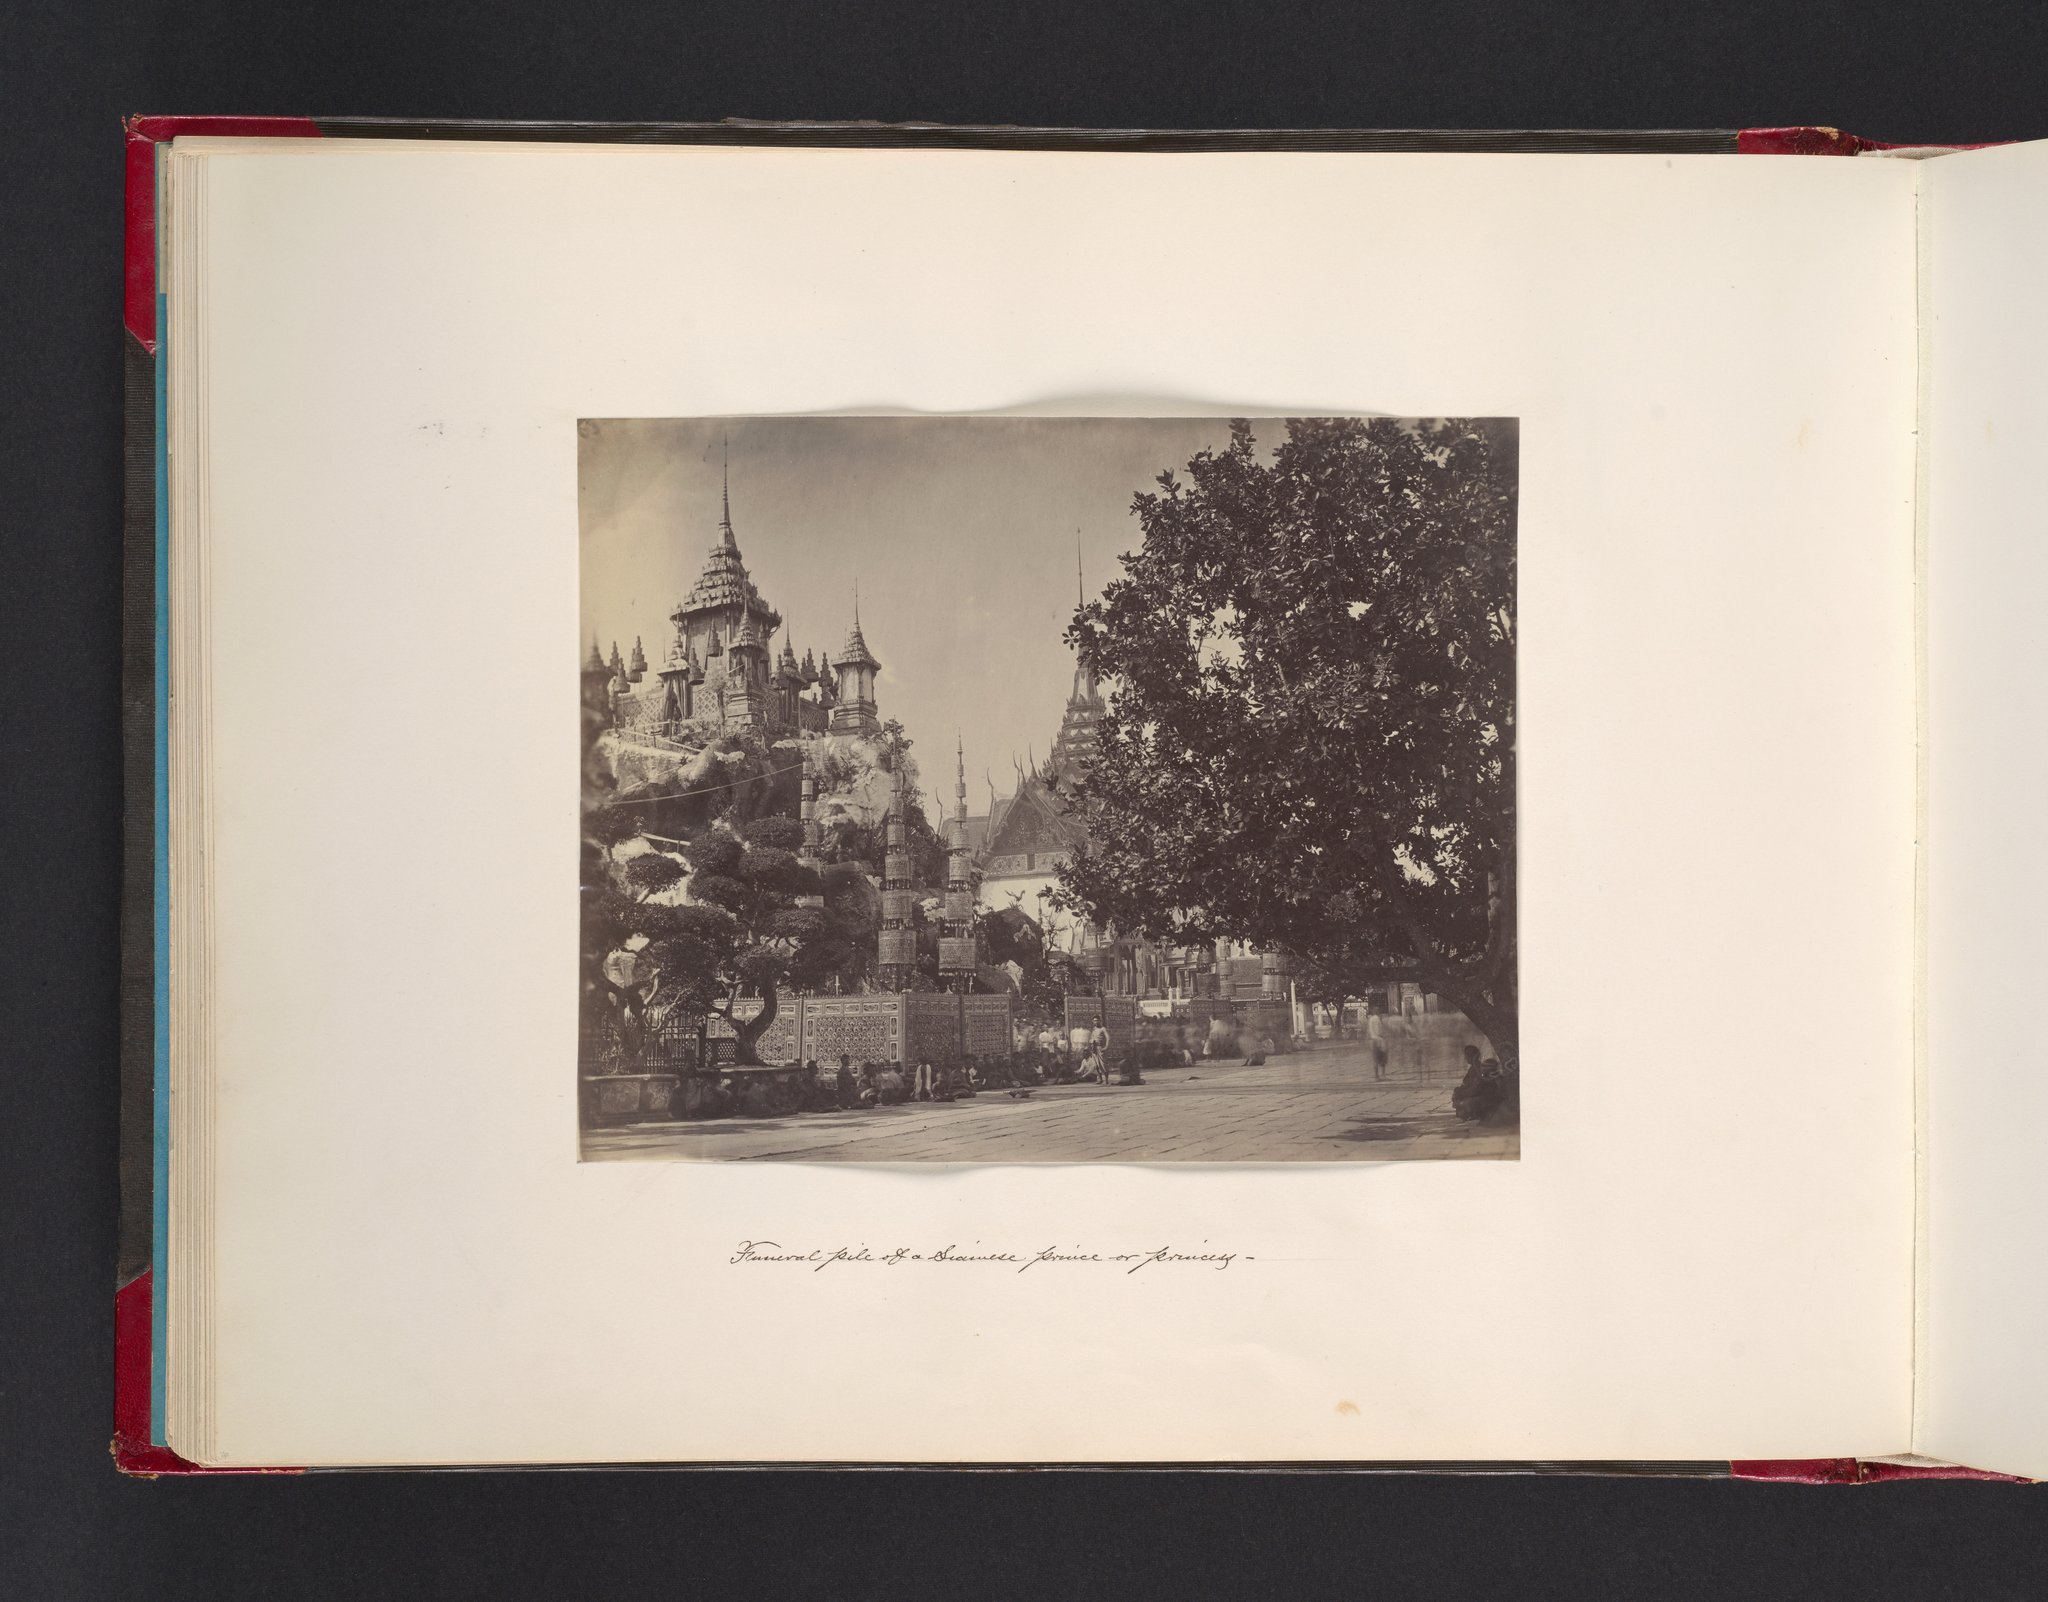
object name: photograph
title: Funeral Pile of a Siamese Prince or Princess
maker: john thomson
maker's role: artist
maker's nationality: british, scottish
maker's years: 1837-1921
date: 1865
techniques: albumen silver print, glass negative